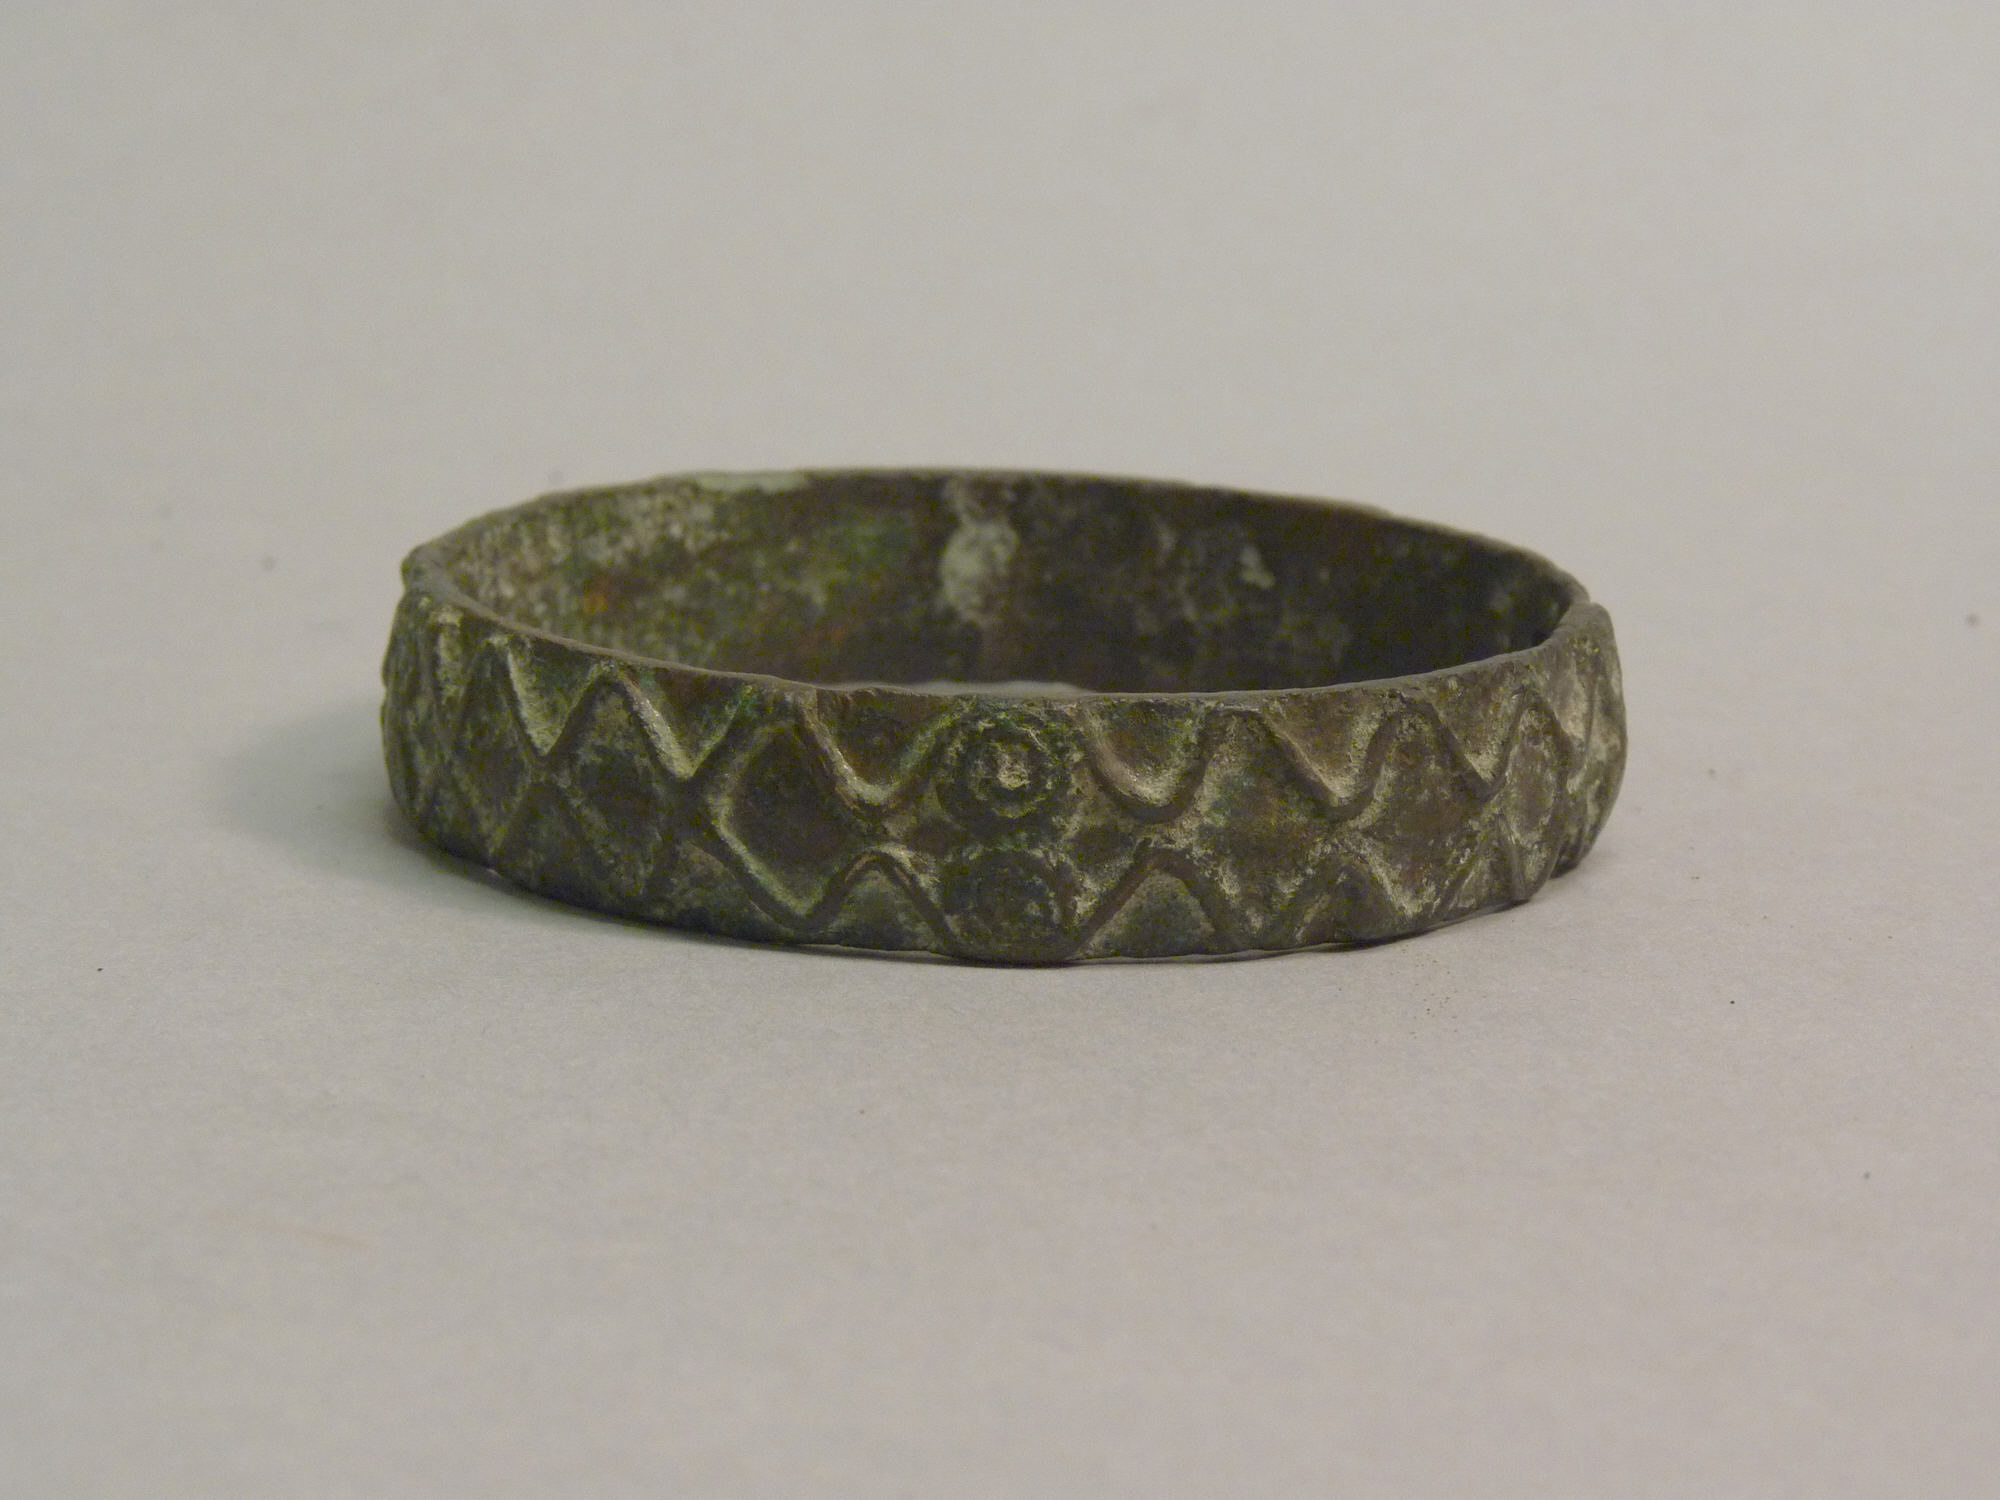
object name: bracelet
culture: vietnamese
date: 500 BCE-300 CE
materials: bronze